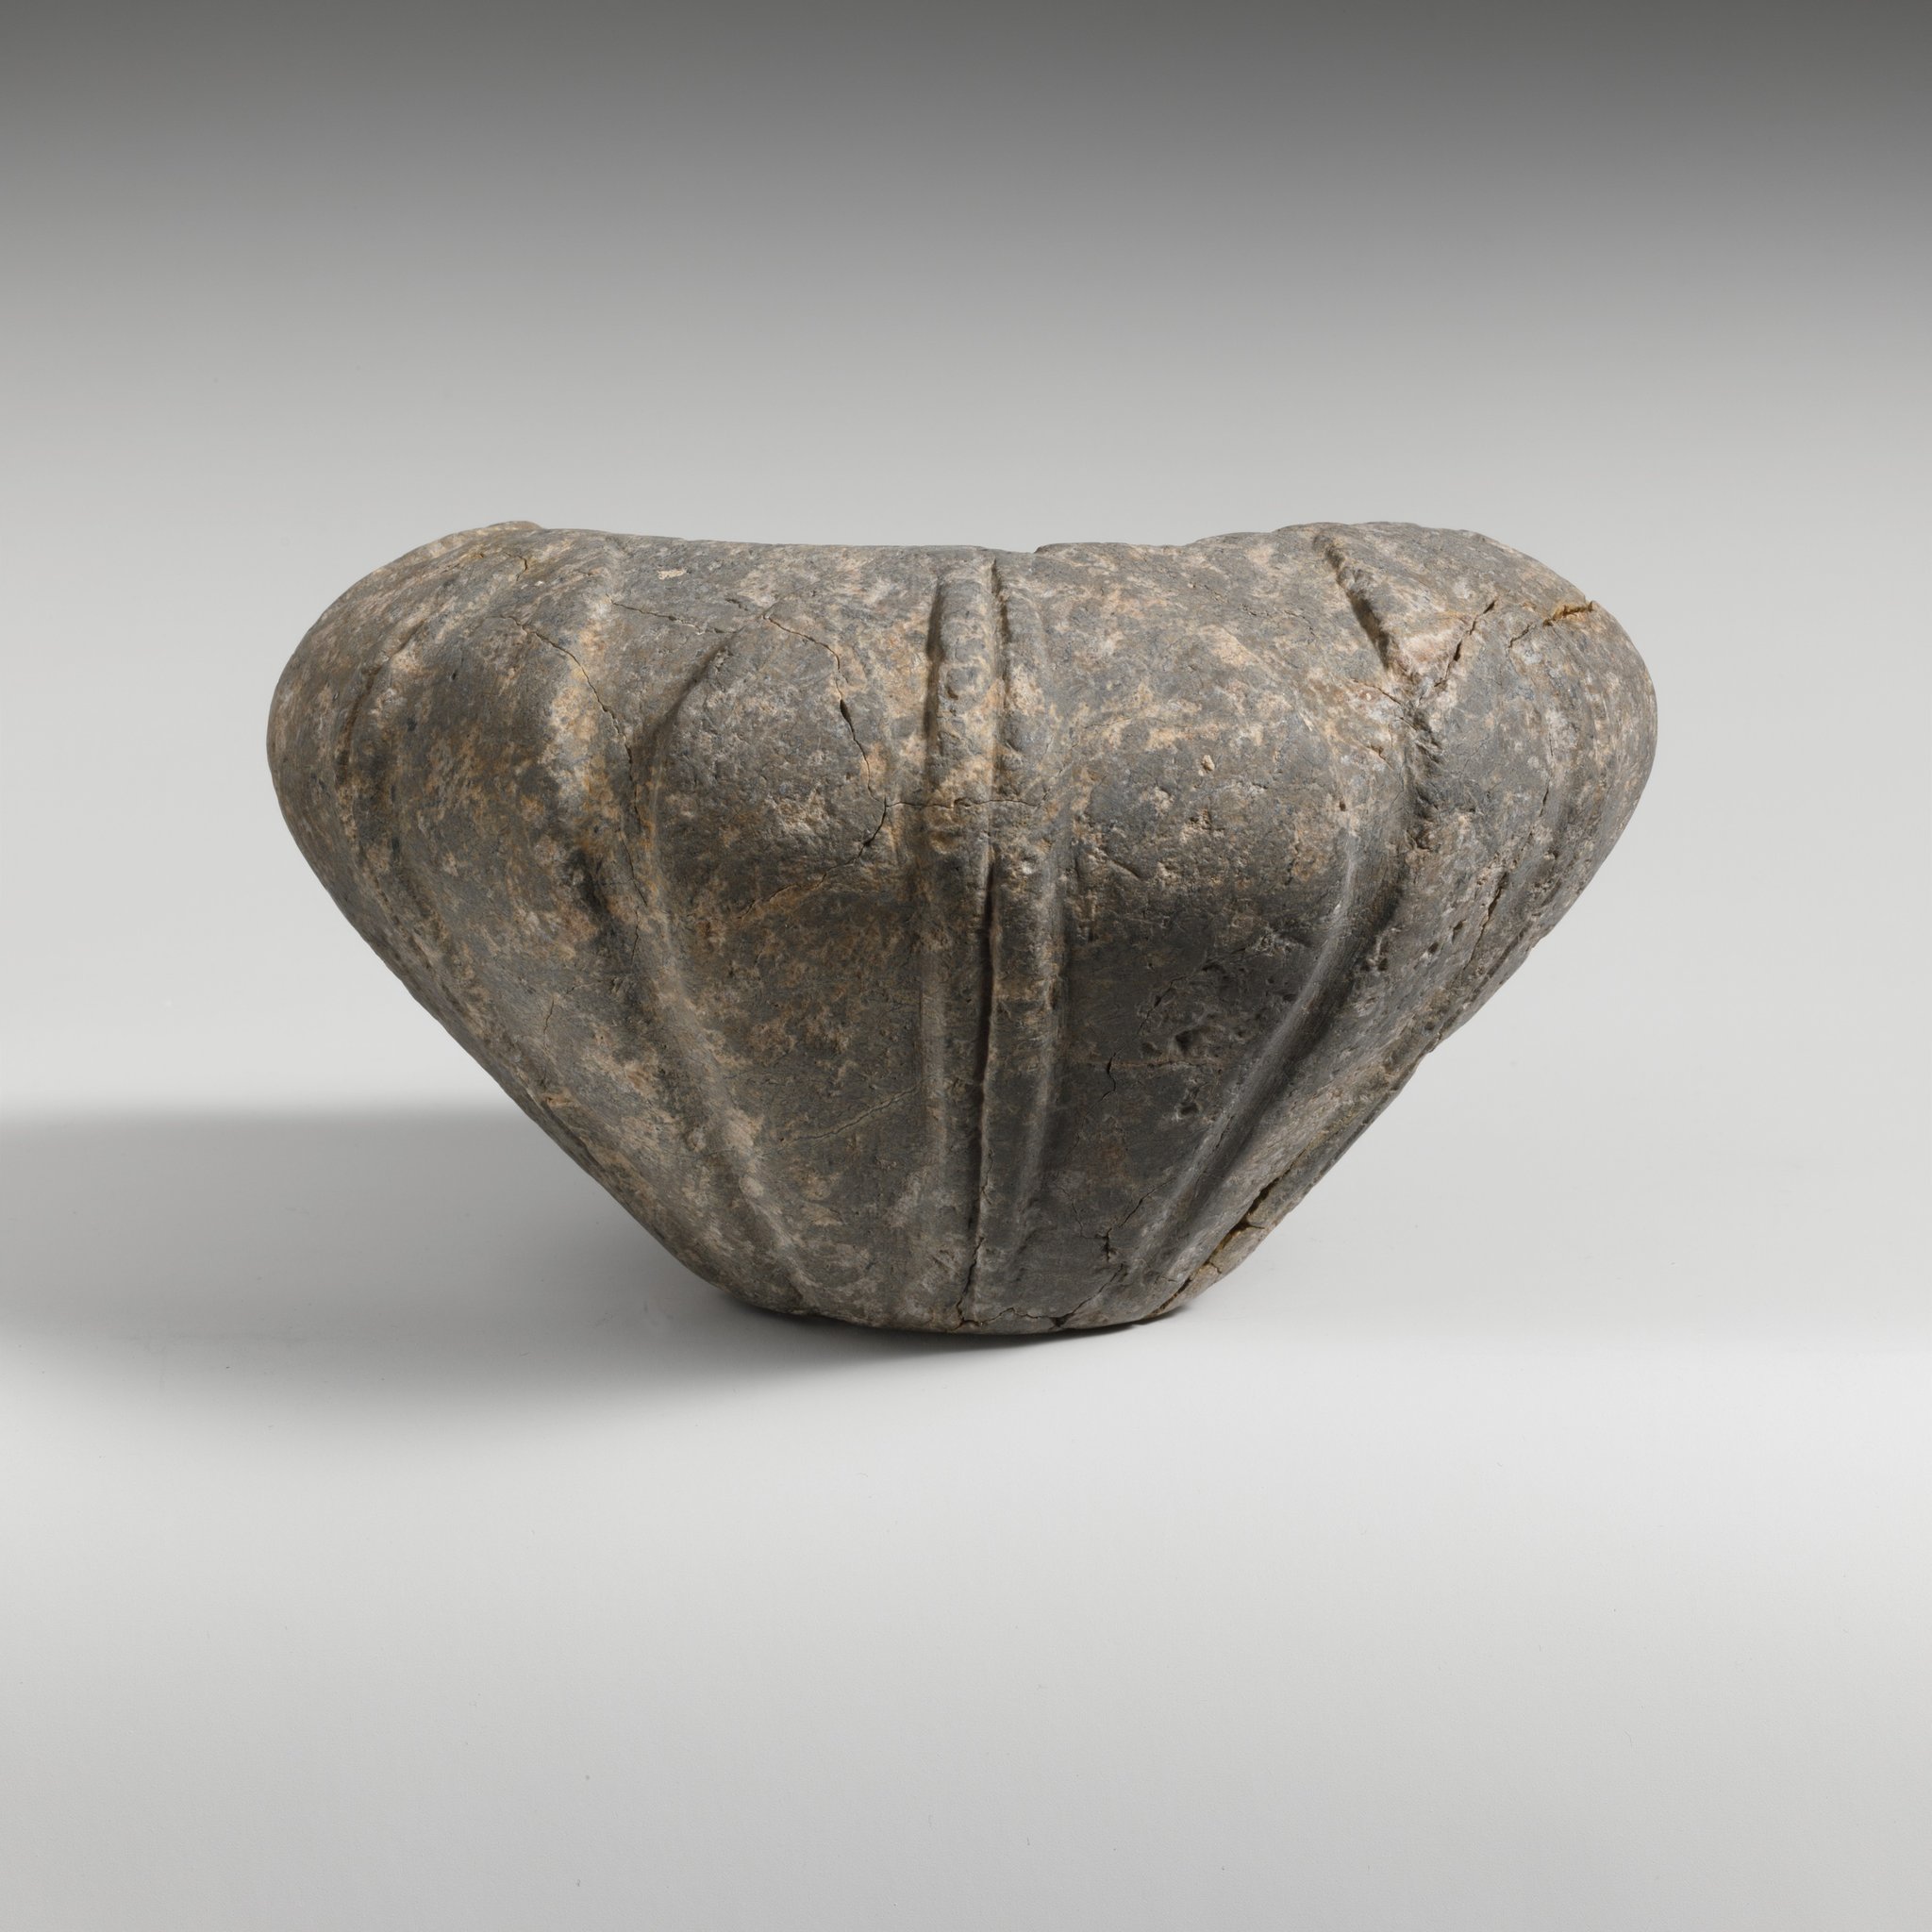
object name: bowl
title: Serpentine blossom bowl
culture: minoan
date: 1750-1450 BCE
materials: stone